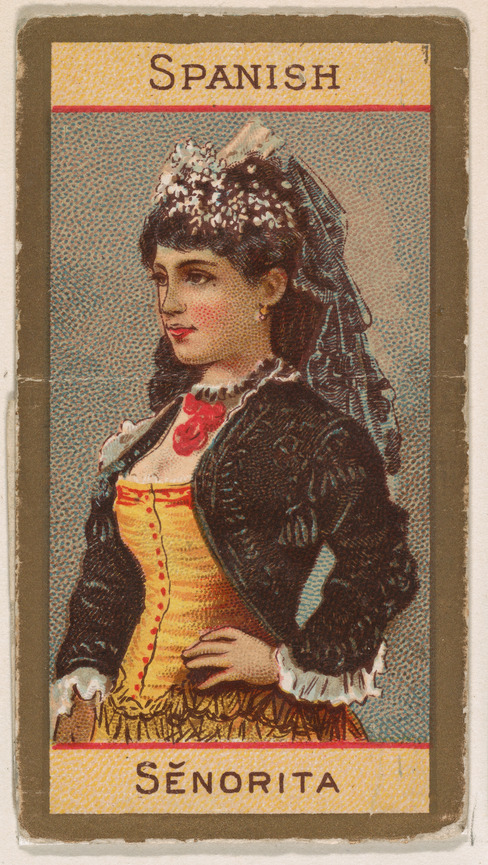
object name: print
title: Spanish, Senorita, from Types of Nationalities (N240) issued by Kinney Bros.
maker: kinney brothers tobacco company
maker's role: publisher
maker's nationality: american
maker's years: 1869-2011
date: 1890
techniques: color lithograph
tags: women